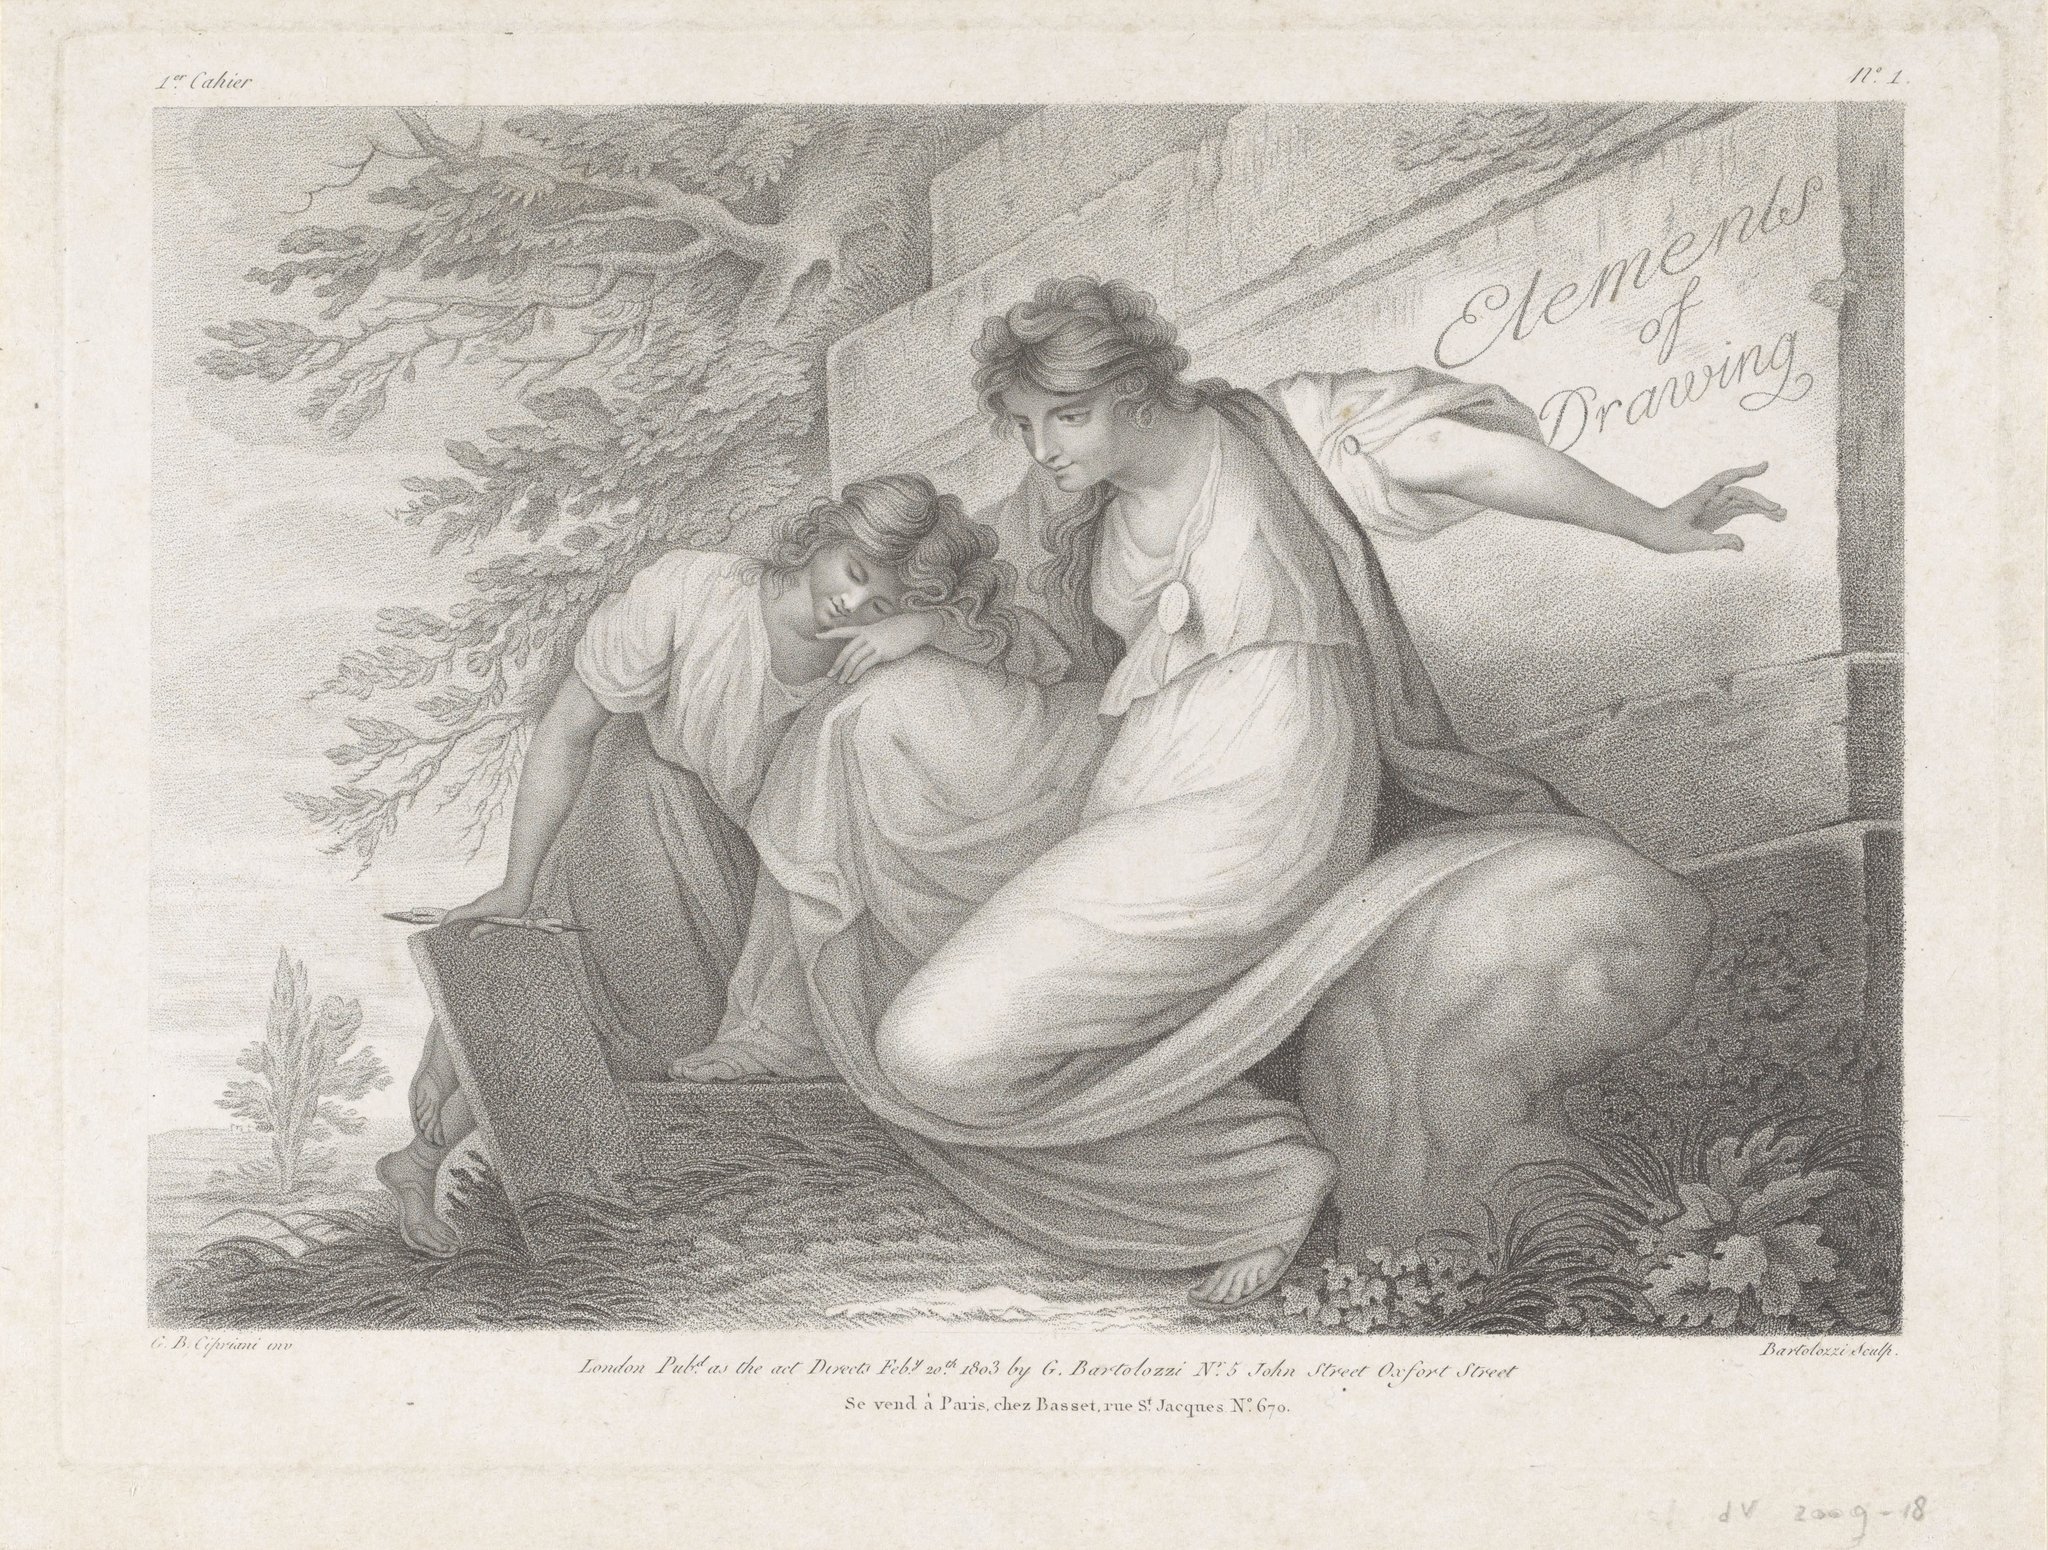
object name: titelprent, frontispice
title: Titelprent met twee figuren met een tekening in een landschap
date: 1803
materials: paper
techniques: etching, engraving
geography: paris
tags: drawing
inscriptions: collector's mark: Lugt 2228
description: Twee vrouwenfiguren kijken naar een tablet met daarop een tekening. Een van de vrouwen houdt een pen in haar hand. Genummerd linksboven: 1er Cahier.